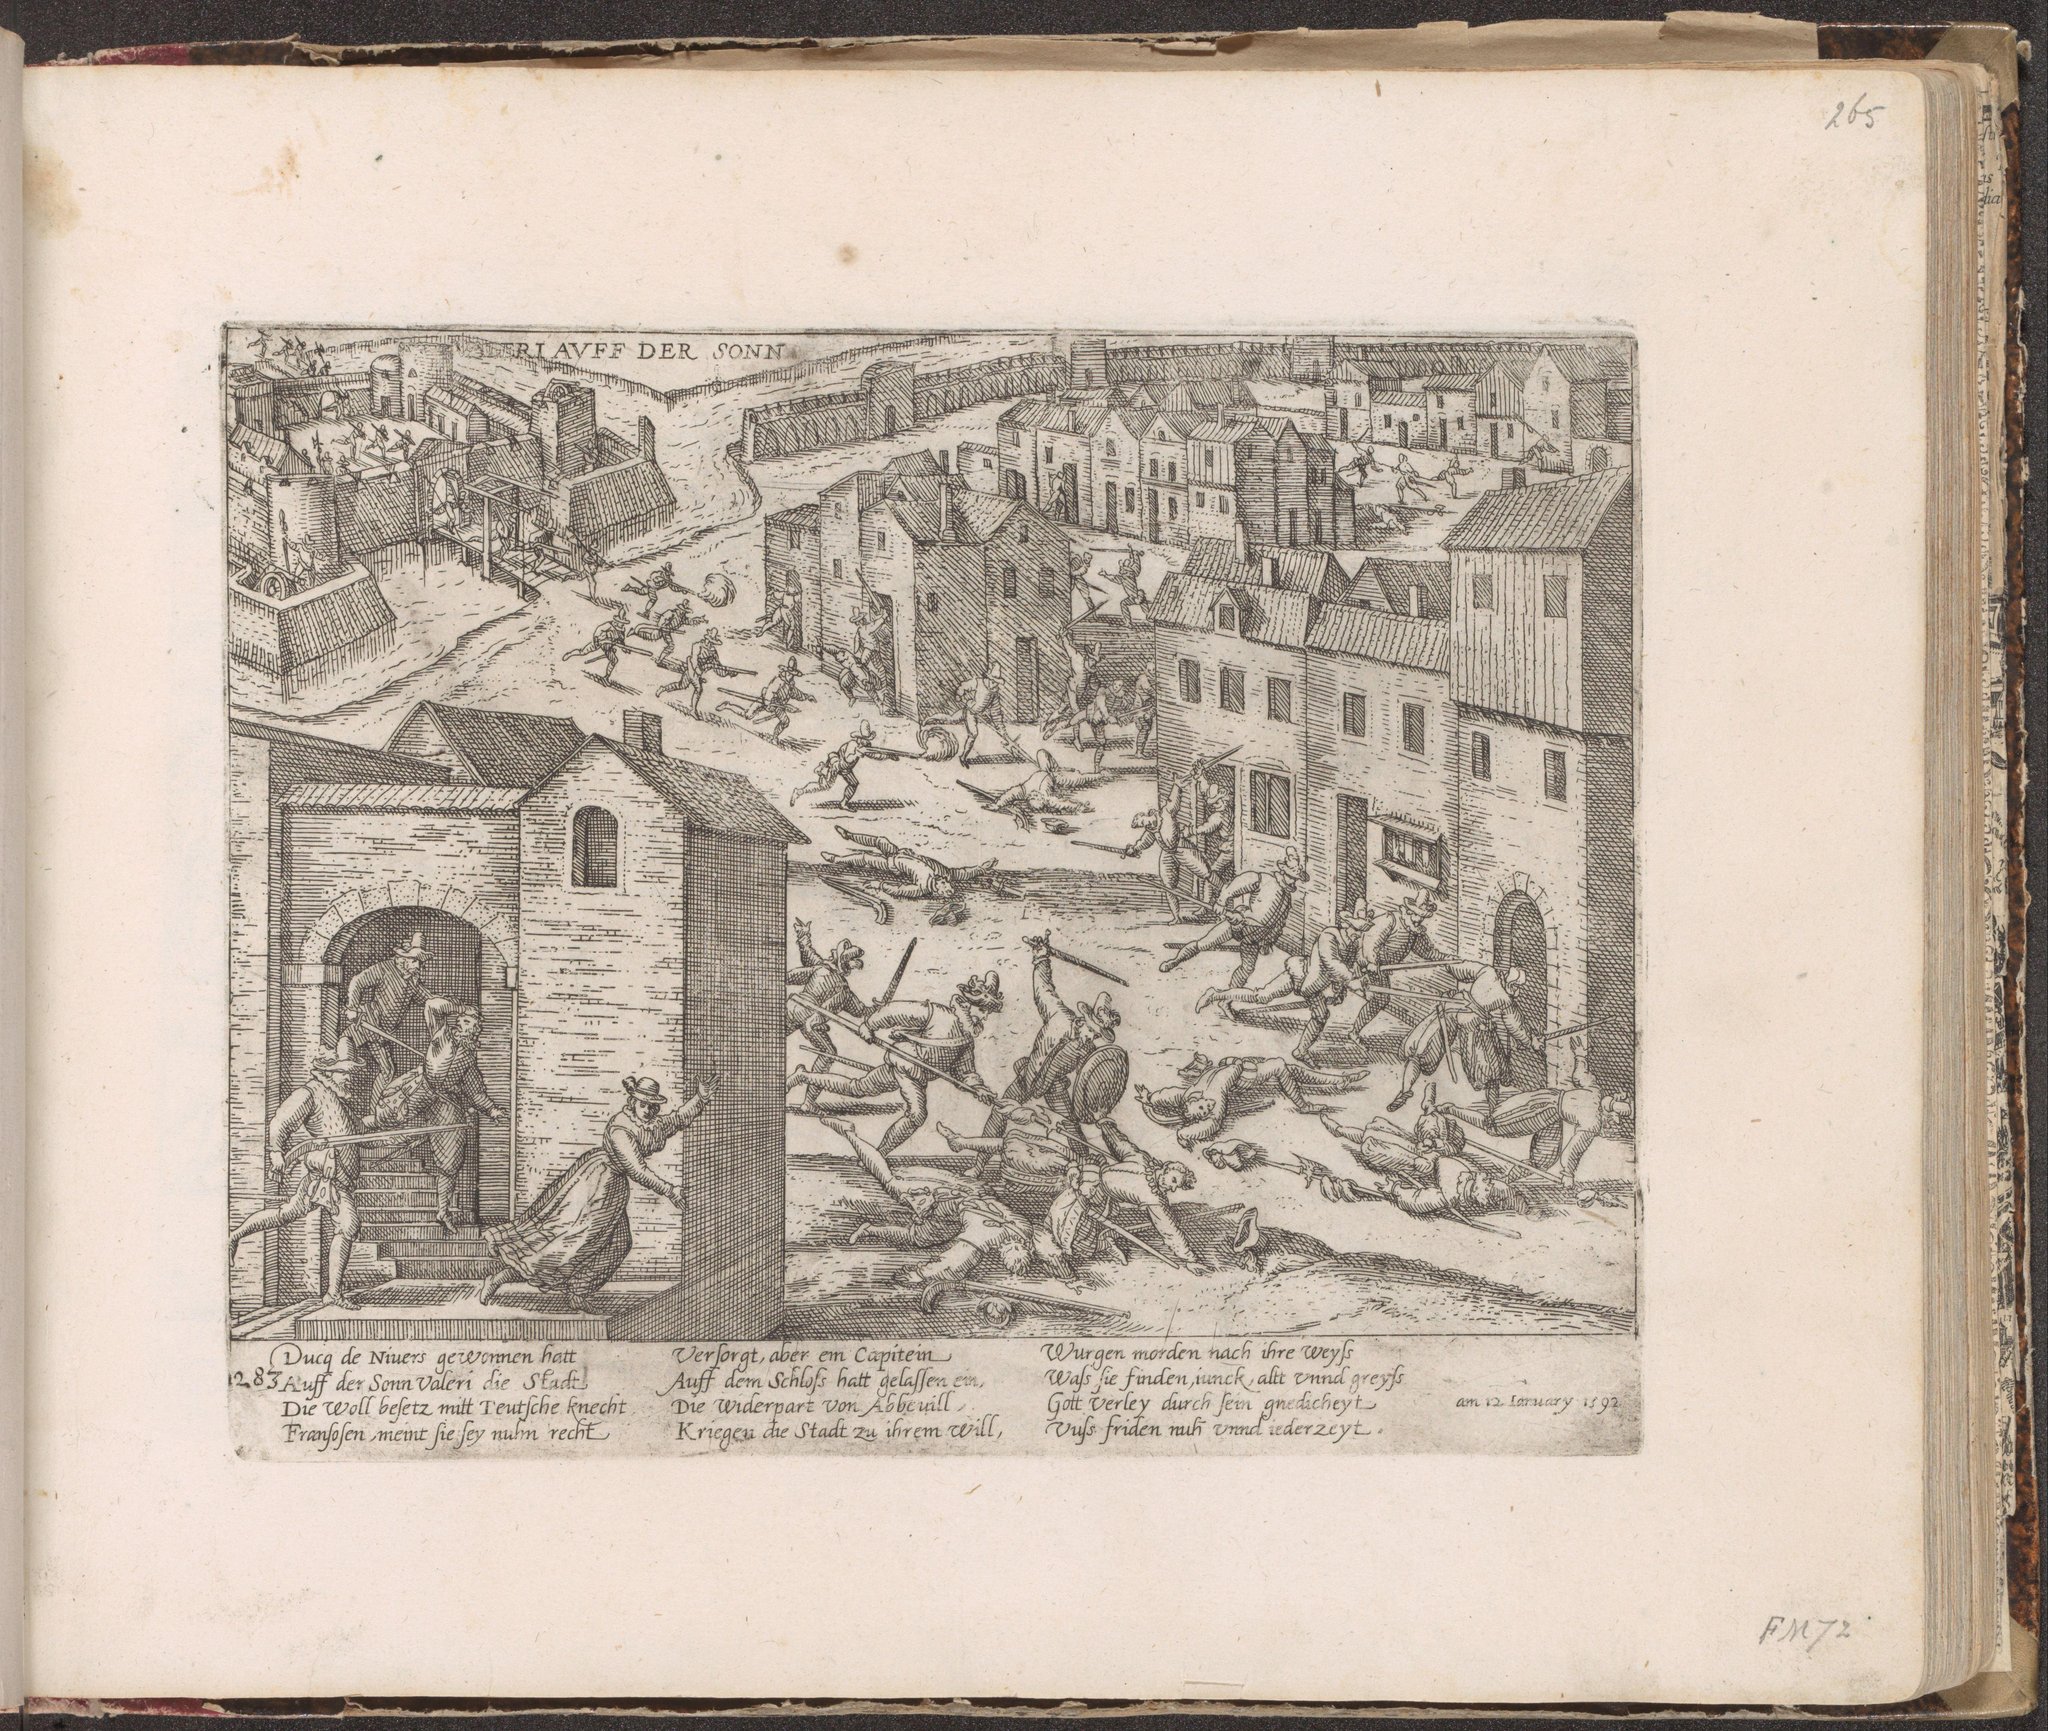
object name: history print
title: Overval op Saint-Valery-sur-Somme, 1592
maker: frans hogenberg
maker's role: print maker, publisher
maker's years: 1538-1590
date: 1591-1593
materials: paper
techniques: etching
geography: cologne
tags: massacre ~ war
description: Overval op Saint-Valery-sur-Somme, 12 januari 1592. Soldaten doden burgers in de starten van de stad. Met onderschrift van 12 regels in het Duits. Linksonder genummerd: 283. De prent maakt deel uit van een album.